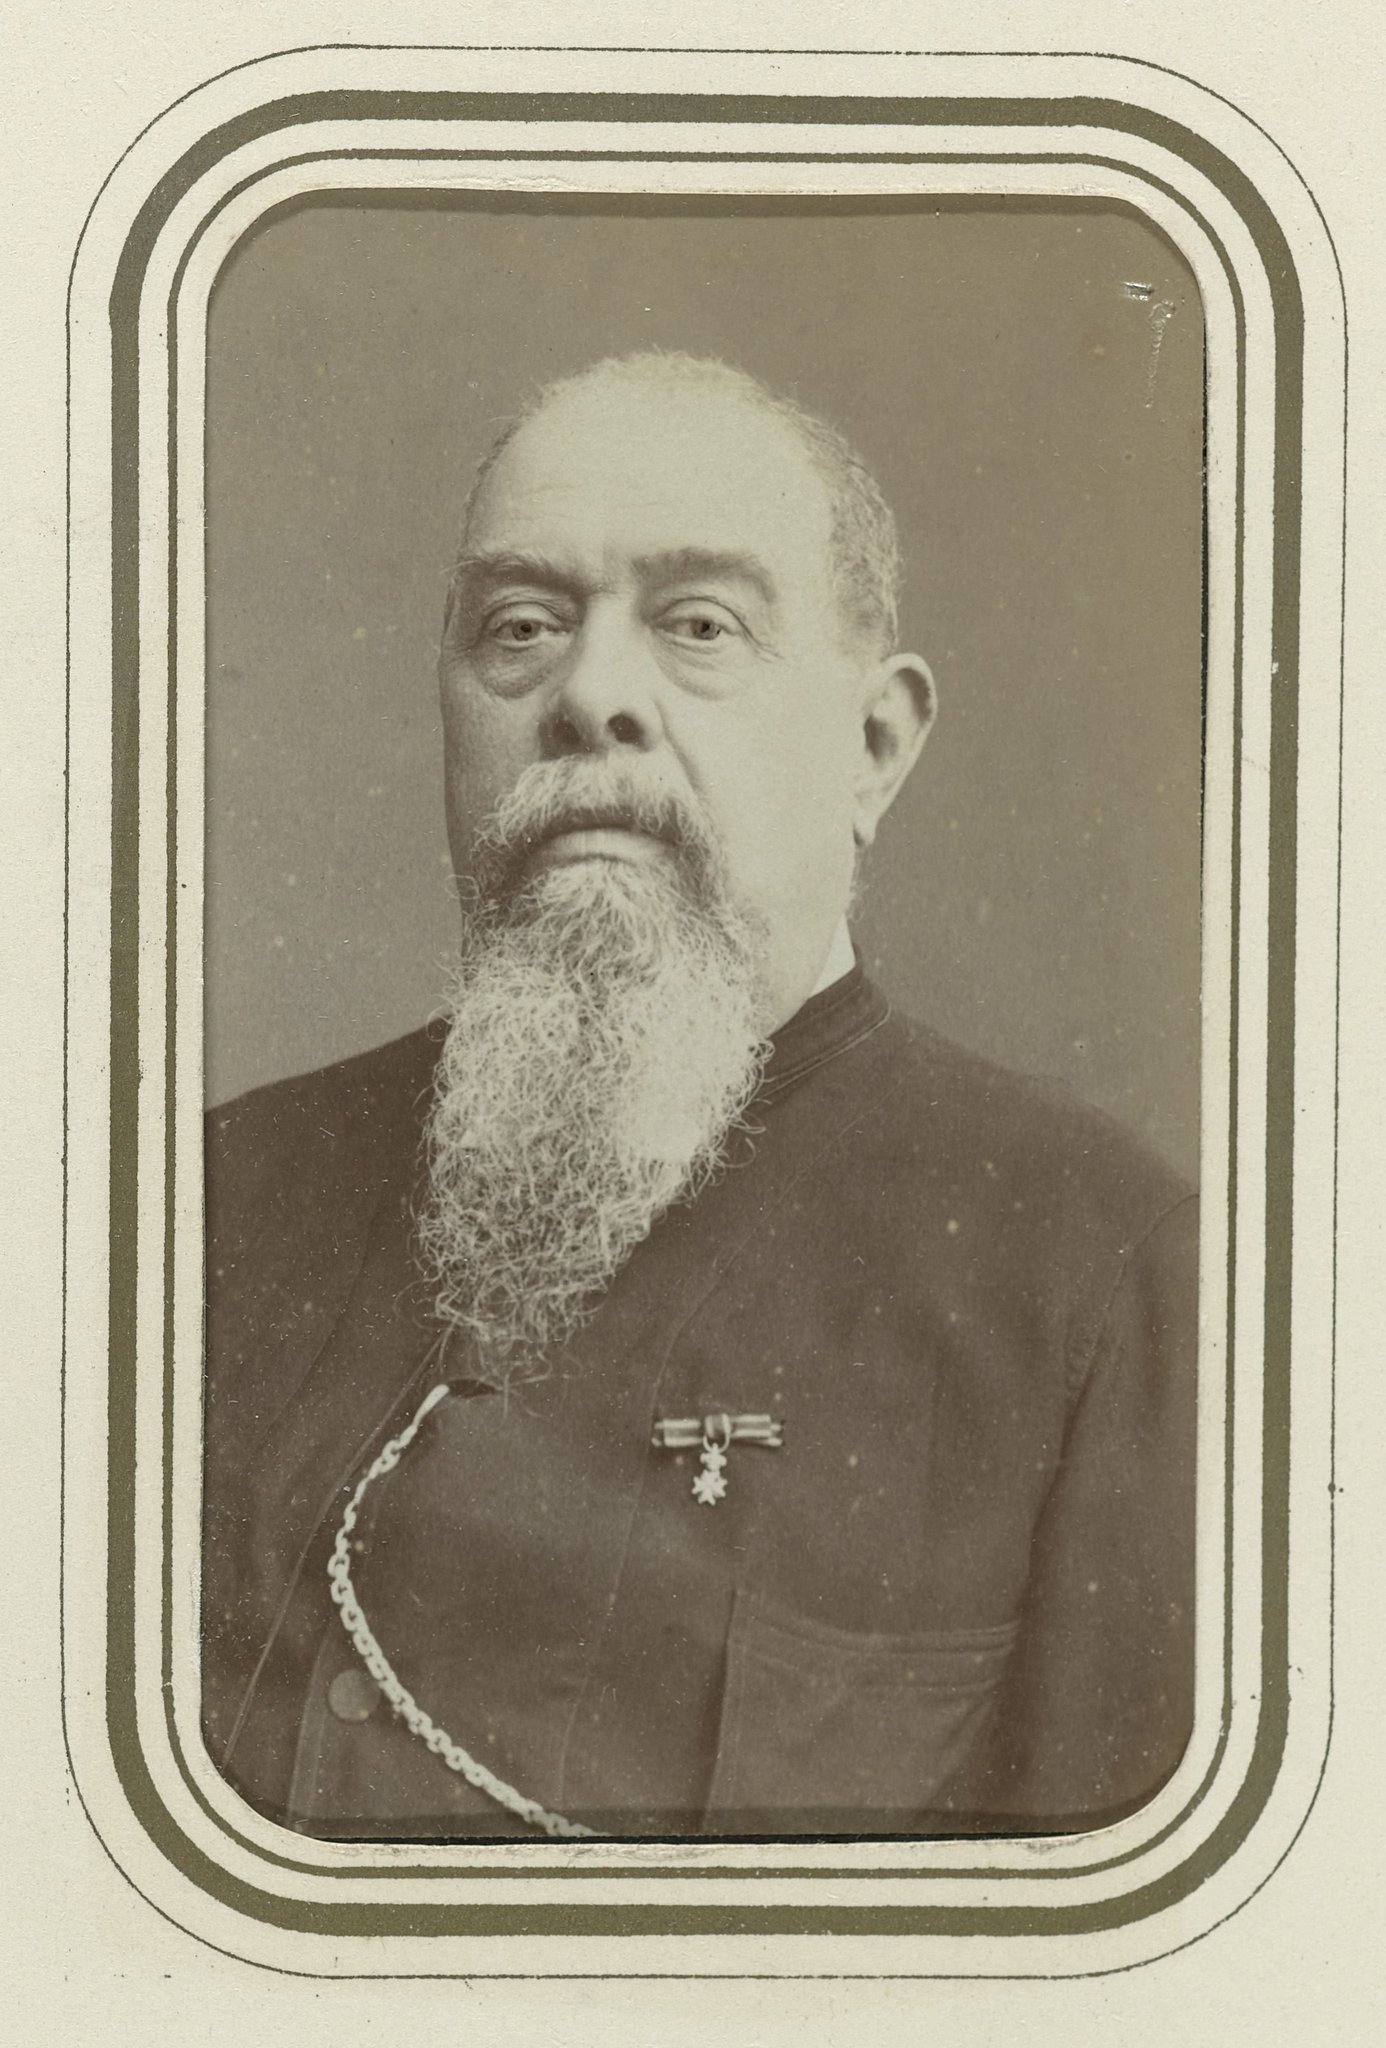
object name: photograph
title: Mansportret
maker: Anonymous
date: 1880-1886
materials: photographic support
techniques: photography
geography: dutch east indies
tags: the hague, anonymous historical person portrayed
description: Carte-de-visite met het portret van een onbekende man. Waarschijnlijk één van de aanbieders van het fotoalbum. Ingestoken in het fotoalbum aangeboden aan J.M. Pijnacker Hordijk bij zijn vertrek uit Jogyakarta in 1886.